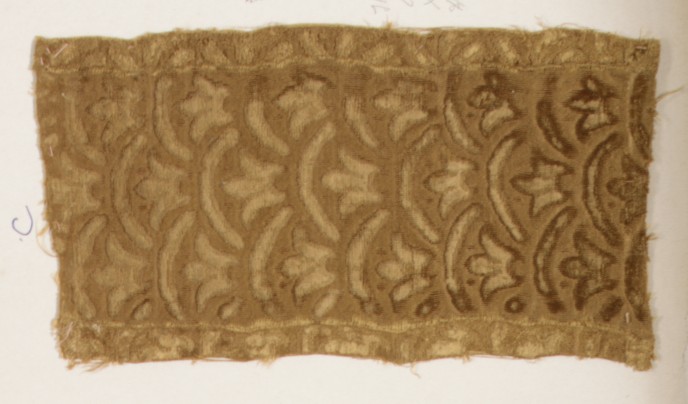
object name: fragment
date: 1601-1800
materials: silk